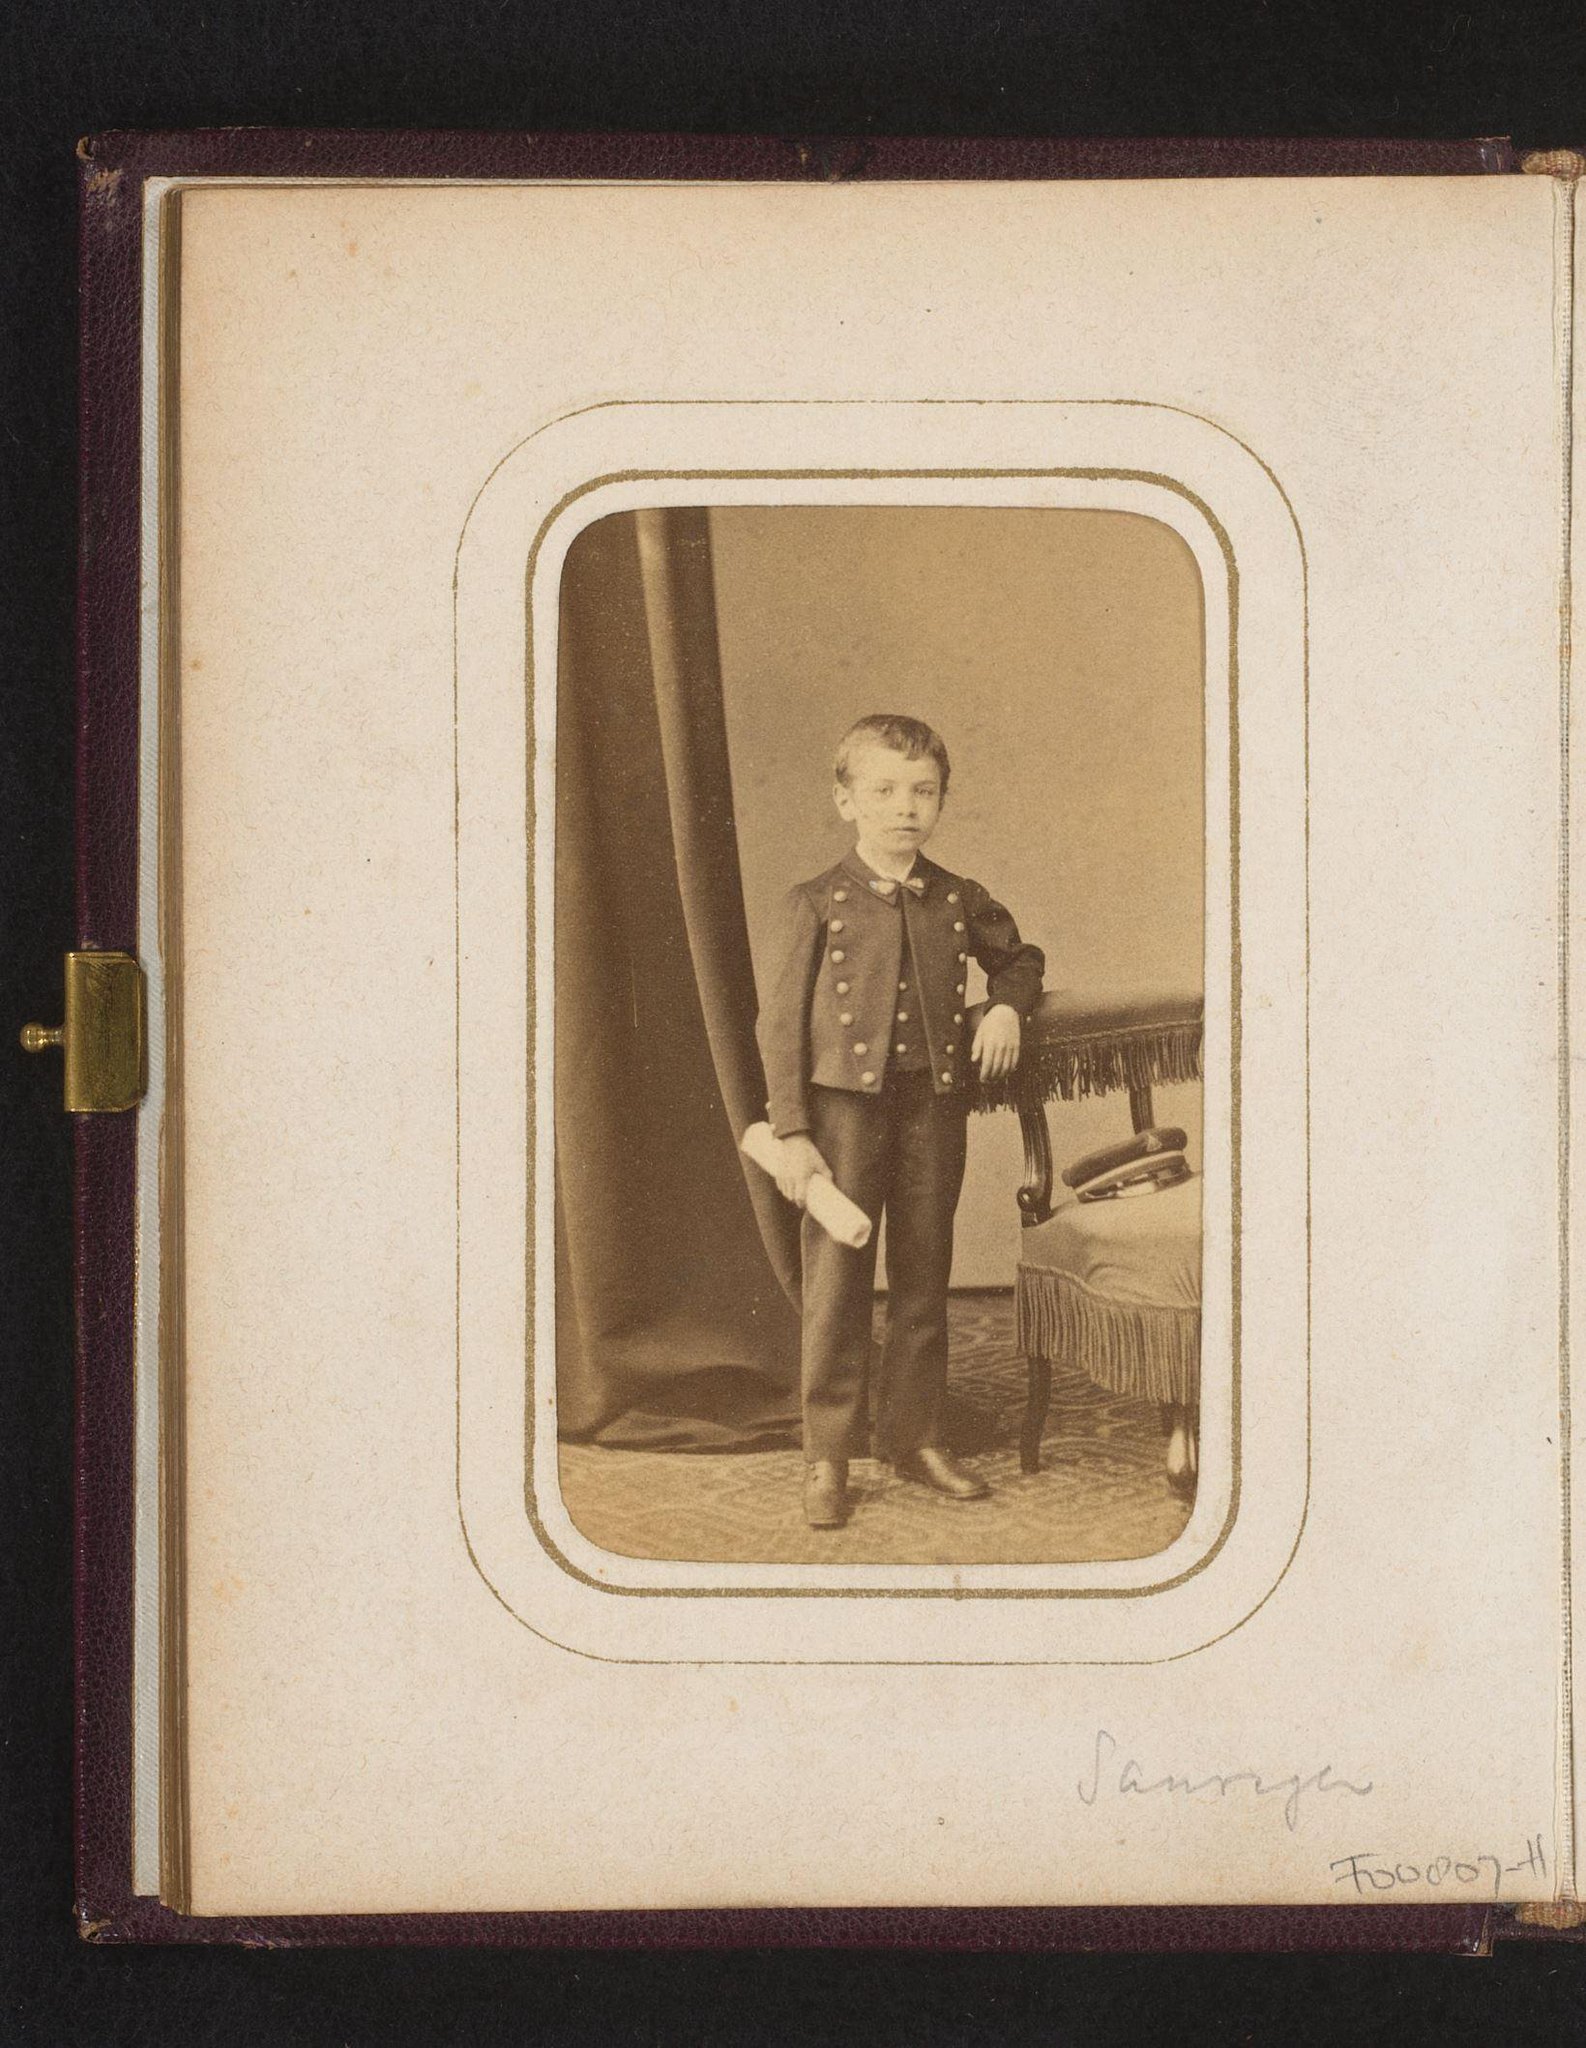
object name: carte de visite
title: Portret van een staande jongen met rol papier in de hand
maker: louis sauvager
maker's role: fotograaf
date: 1860-1900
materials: cardboard, photographic support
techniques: albumen print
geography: fontainebleau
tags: historical persons, toddler (female), paper (writing material)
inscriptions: annotation: ‘Sauvager’, inscription: ‘FONTAINEBLEAU/ Grande Rue, 195/ PHOTOGRAPHIE/ L. Sauvager/ VUES DU PALAIS ET DE LA FORÊT’